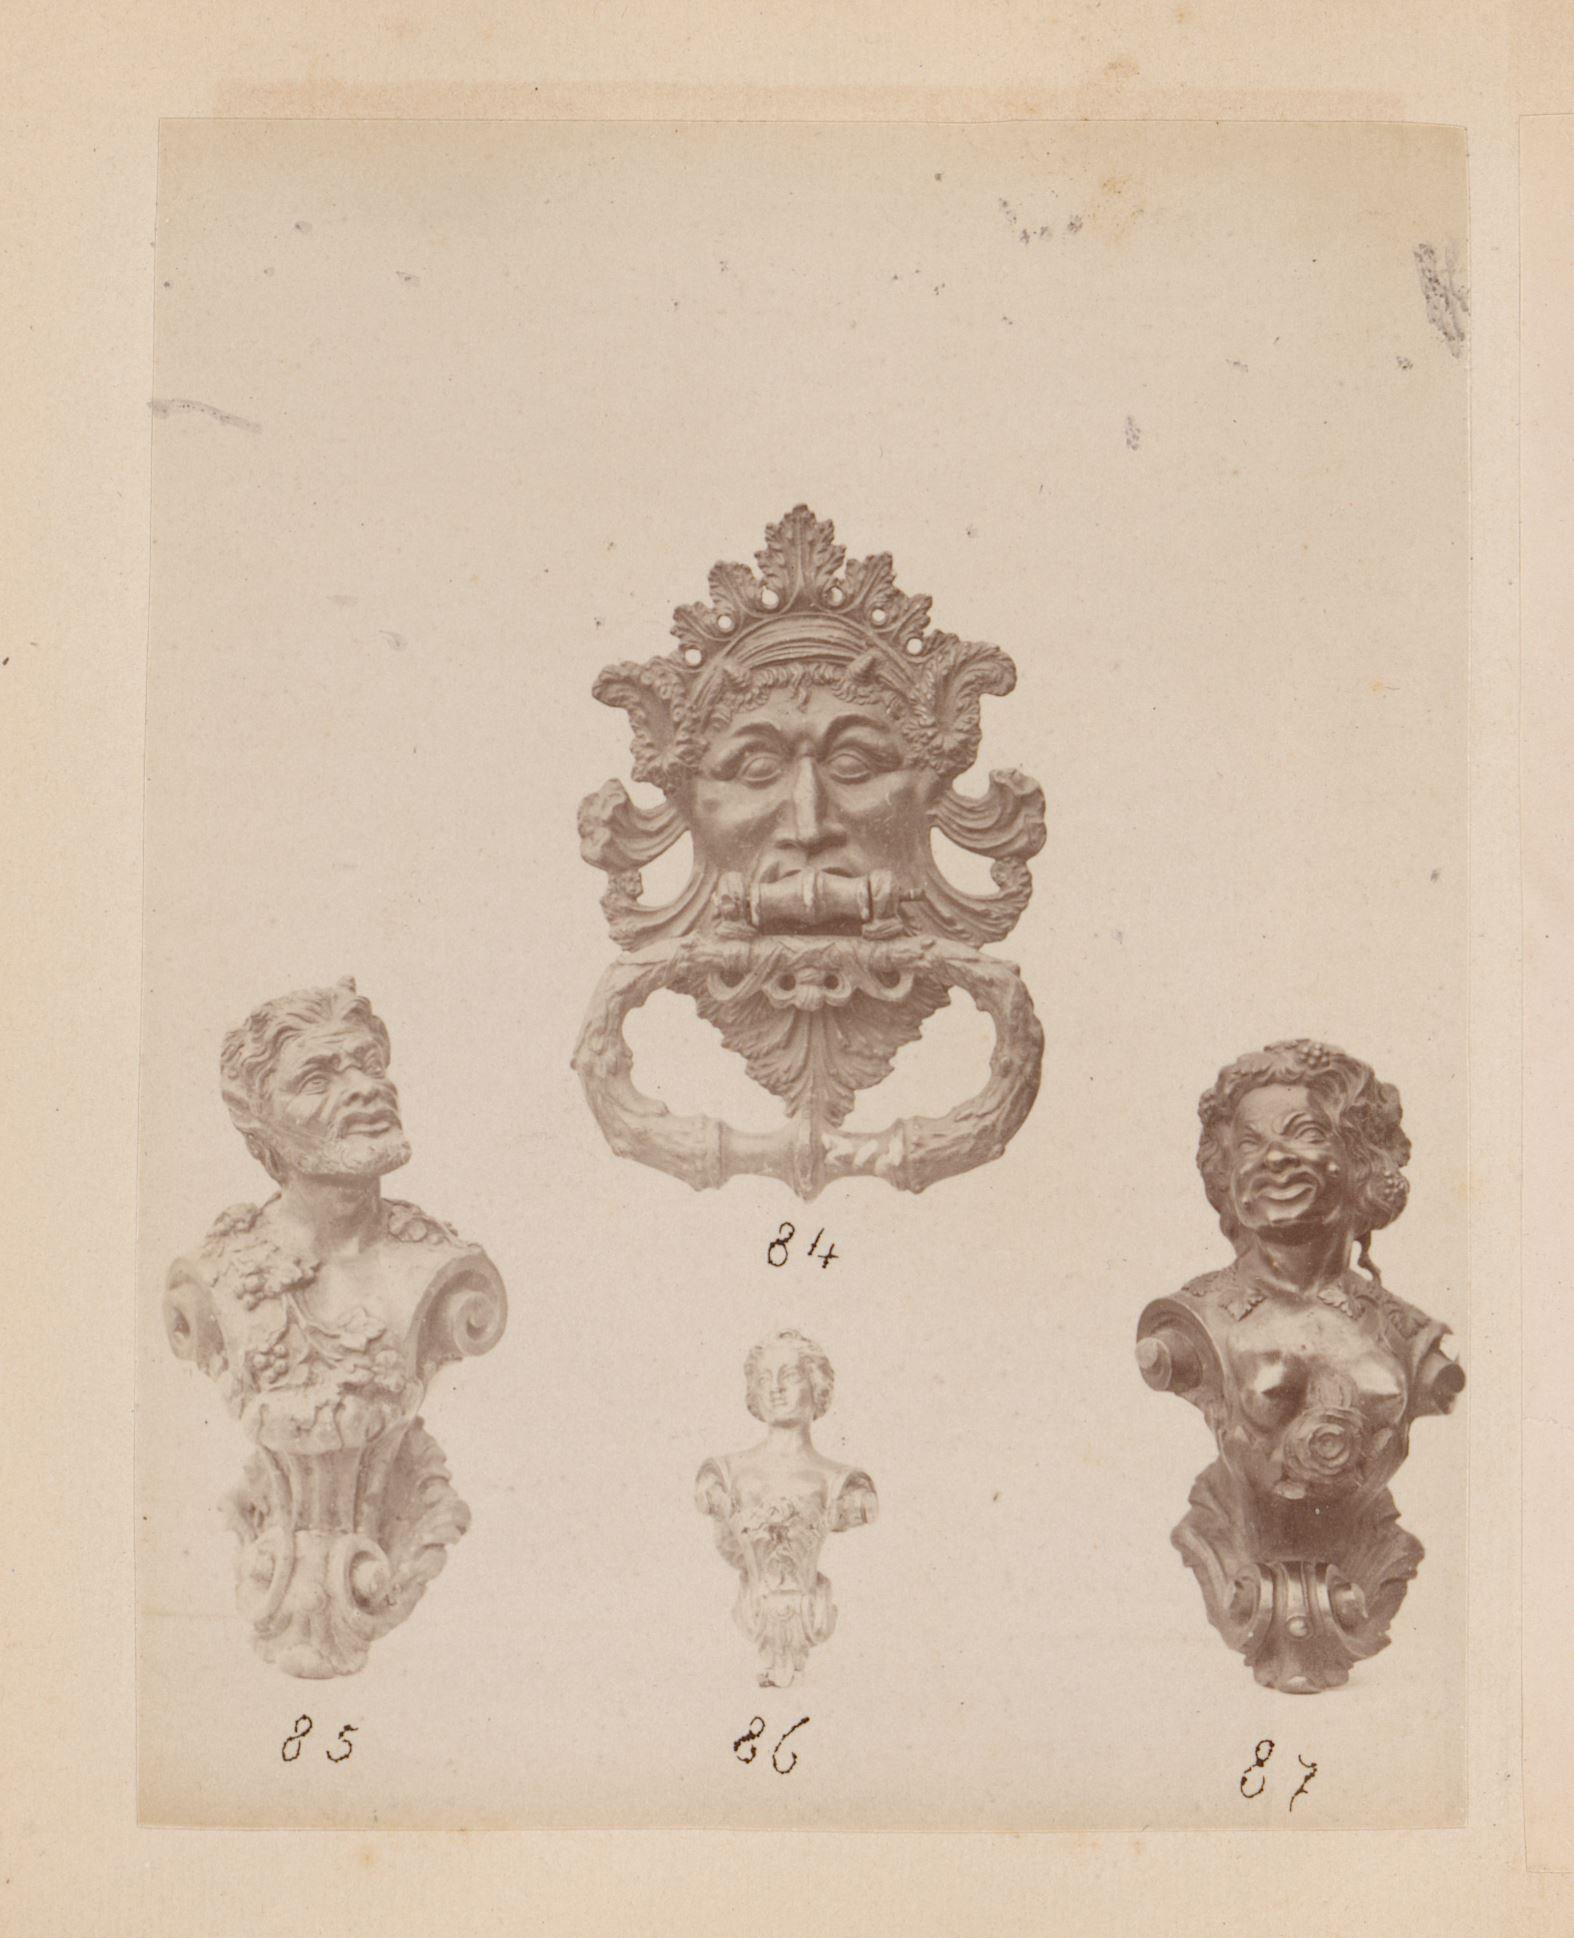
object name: photograph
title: Metalen deurkloppers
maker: Anonymous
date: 1860-1885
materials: photographic support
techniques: albumen print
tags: door-knocker, doorbell